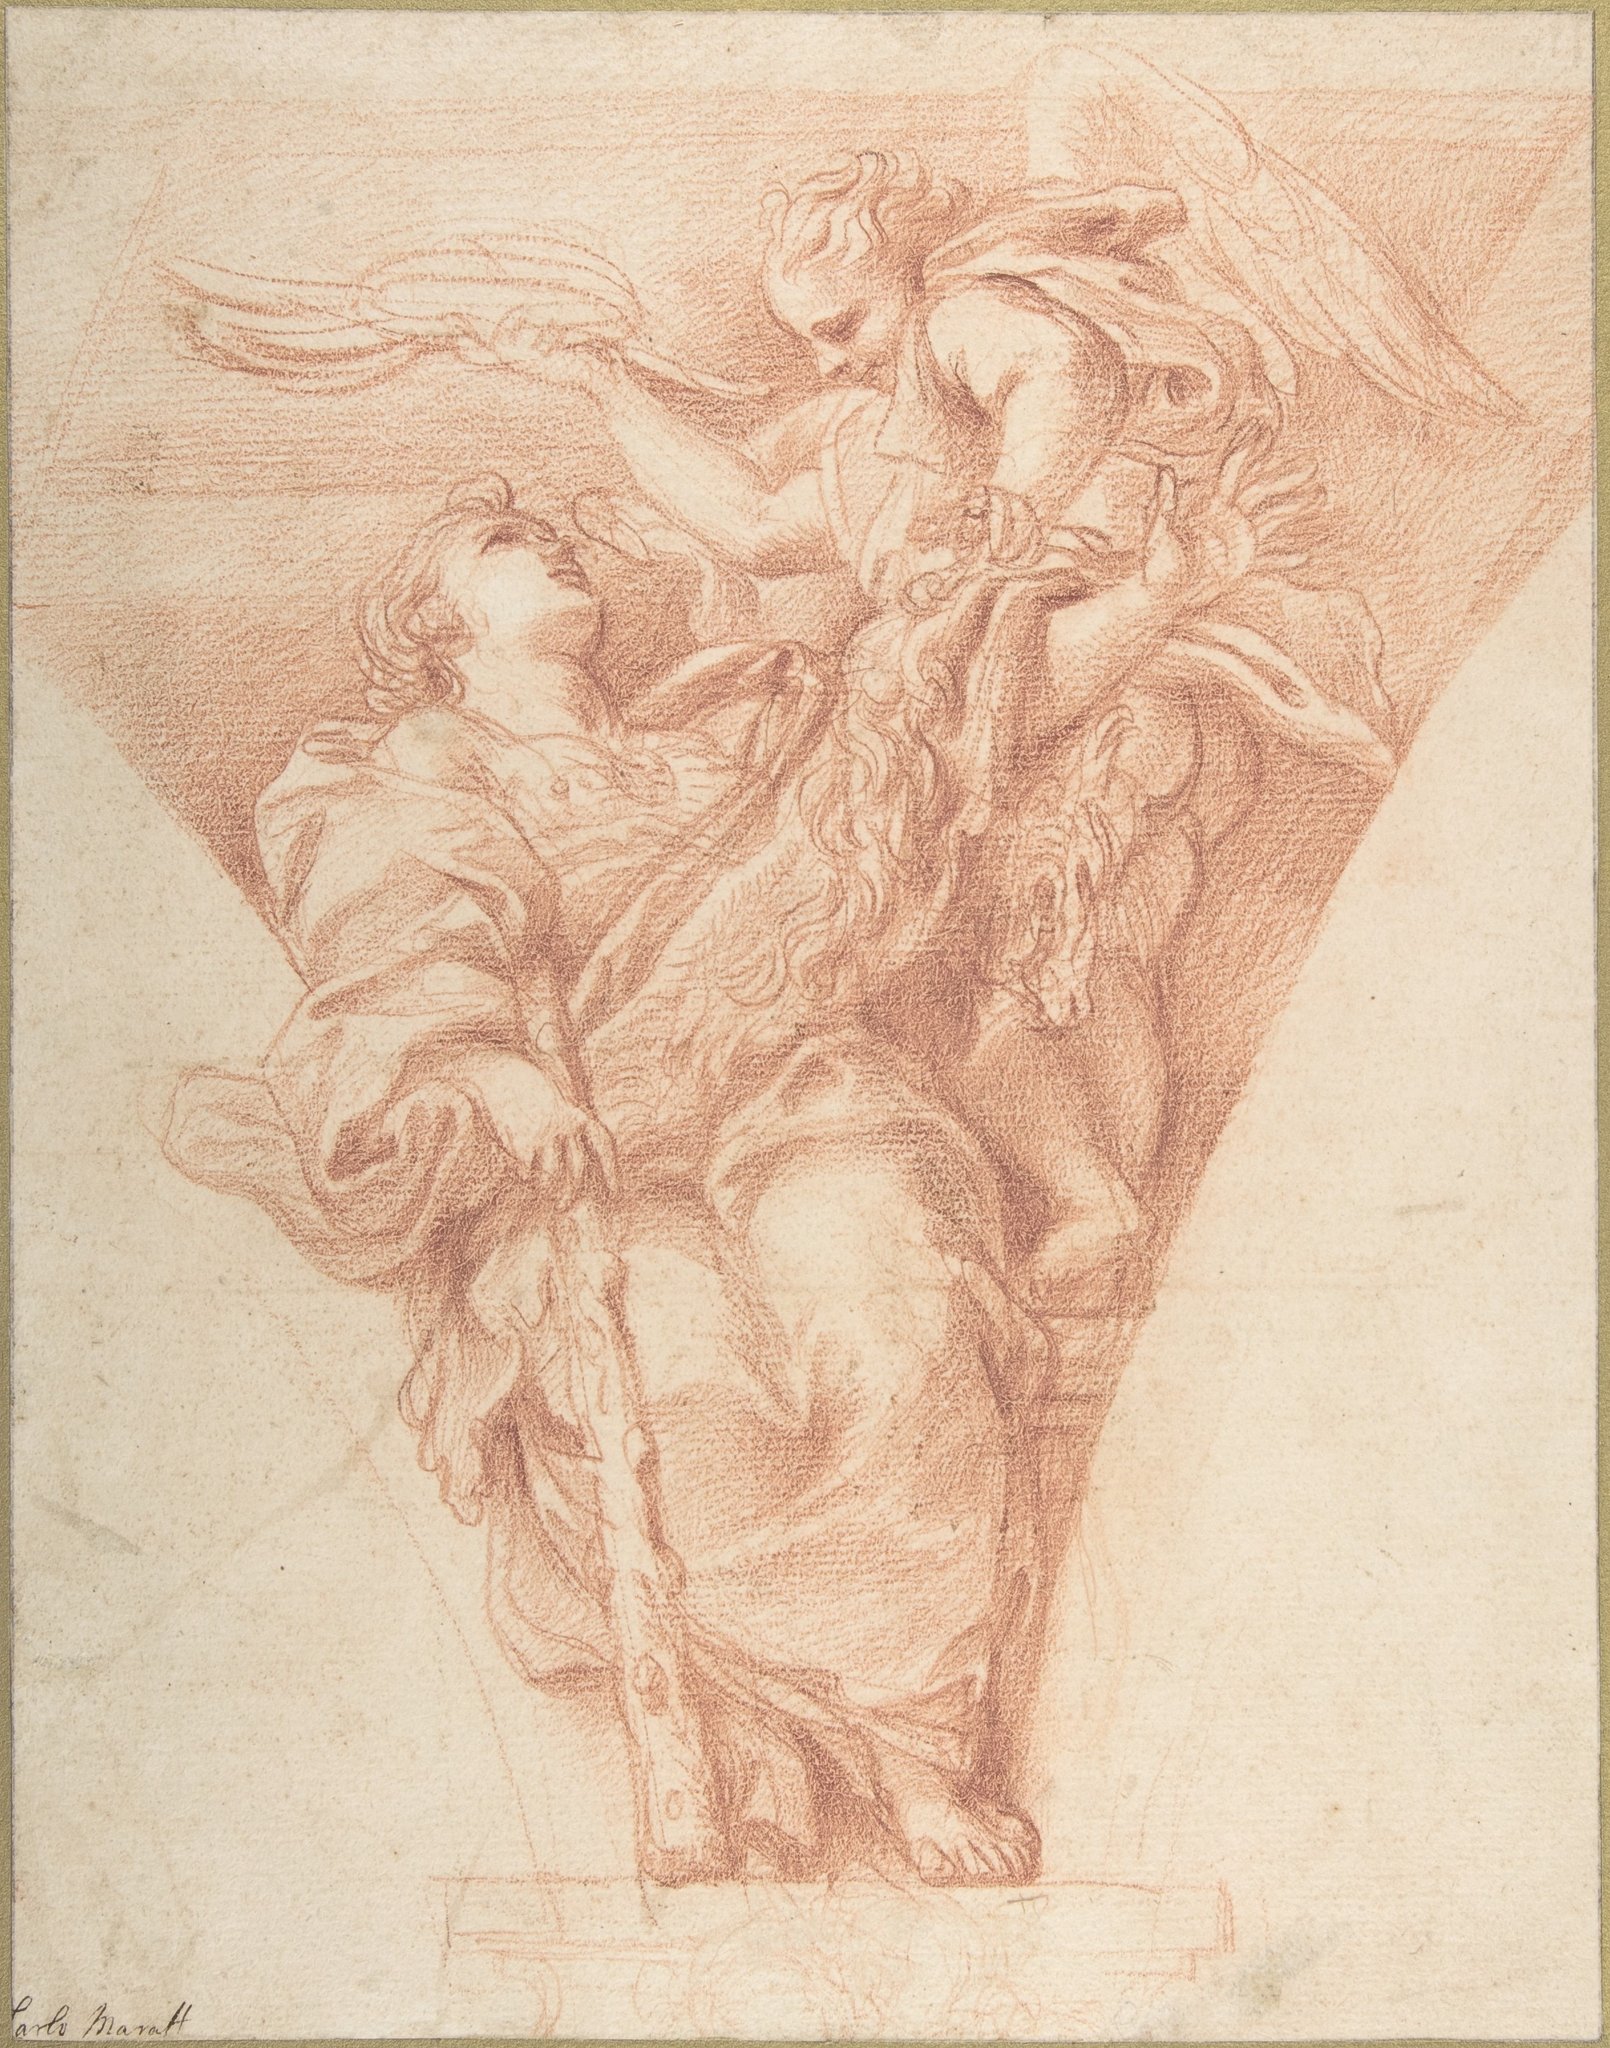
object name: drawing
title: Virtue Crowned by Honor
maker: carlo maratti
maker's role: artist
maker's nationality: italian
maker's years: 1625-1713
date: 1670-1676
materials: chalk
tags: women